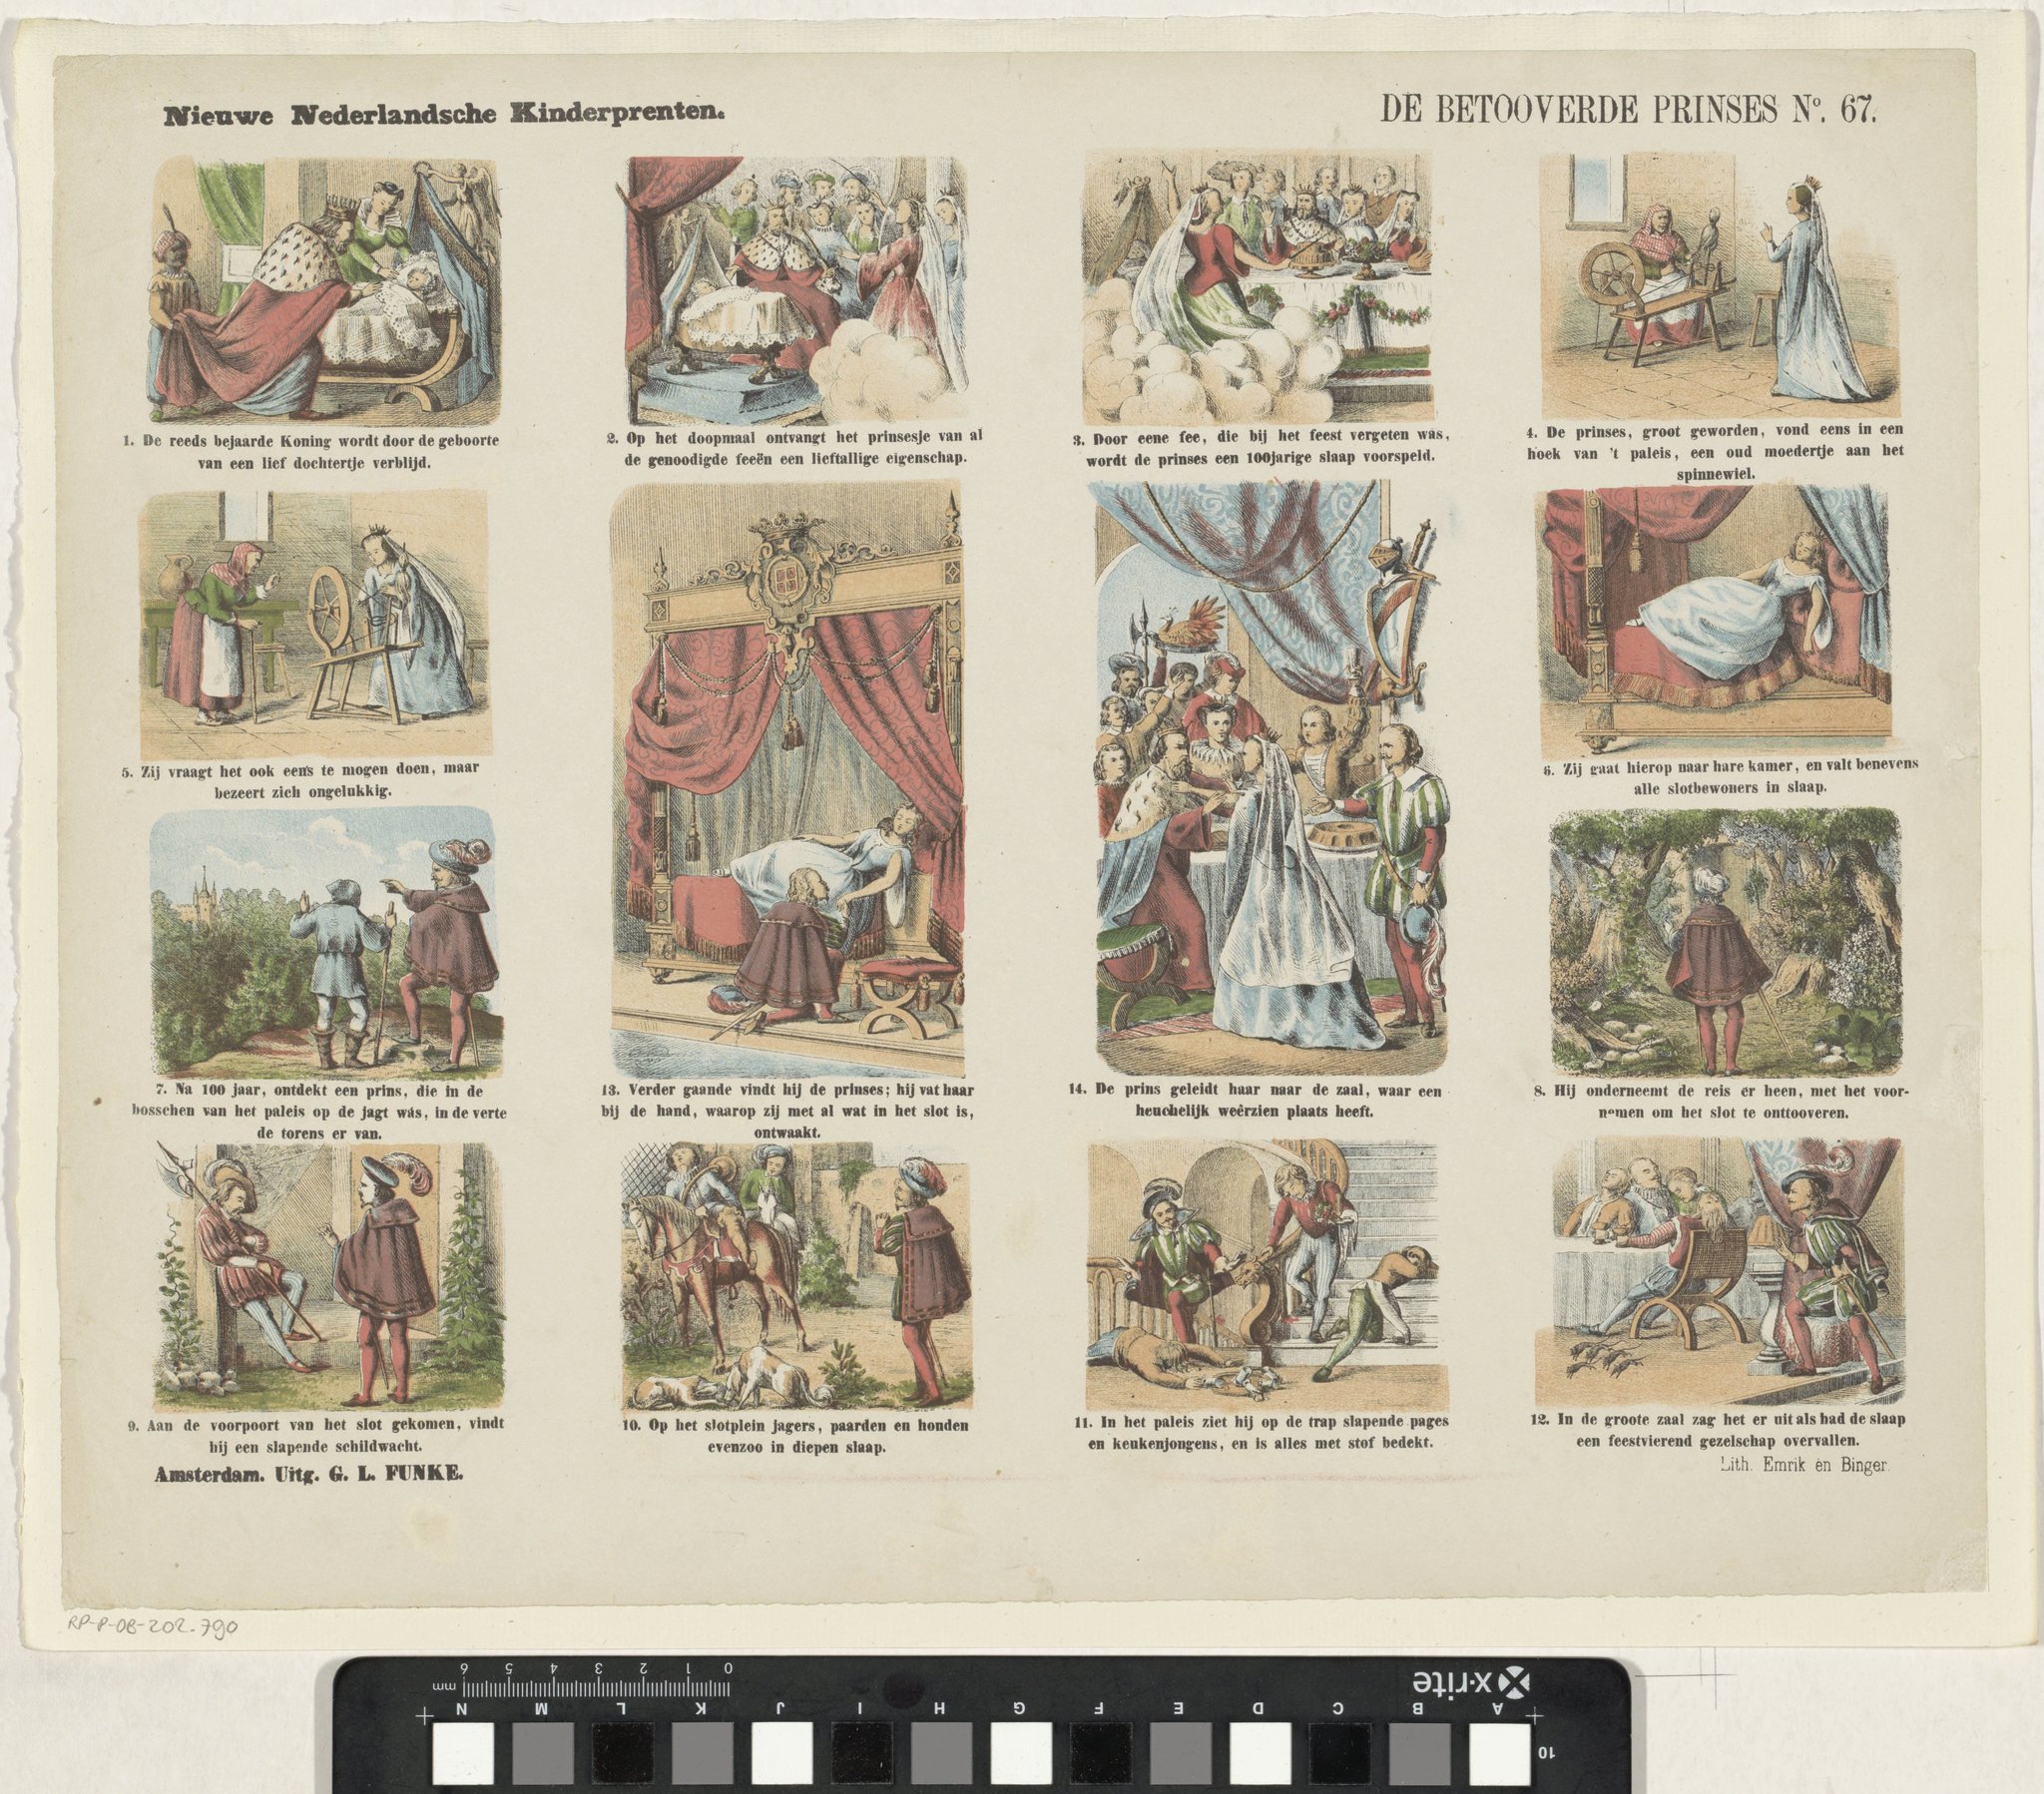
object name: print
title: Nieuwe Nederlandsche kinderprenten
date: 1865-1875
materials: paper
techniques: lithograph, letterpress printing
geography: haarlem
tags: tales and fairy tales: sleeping beauty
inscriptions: collector's mark: Lugt 2760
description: Blad met 14 voorstellingen uit het sprookje van Doornroosje. Onder elke afbeelding een onderschrift. Genummerd rechtsboven: No. 67.